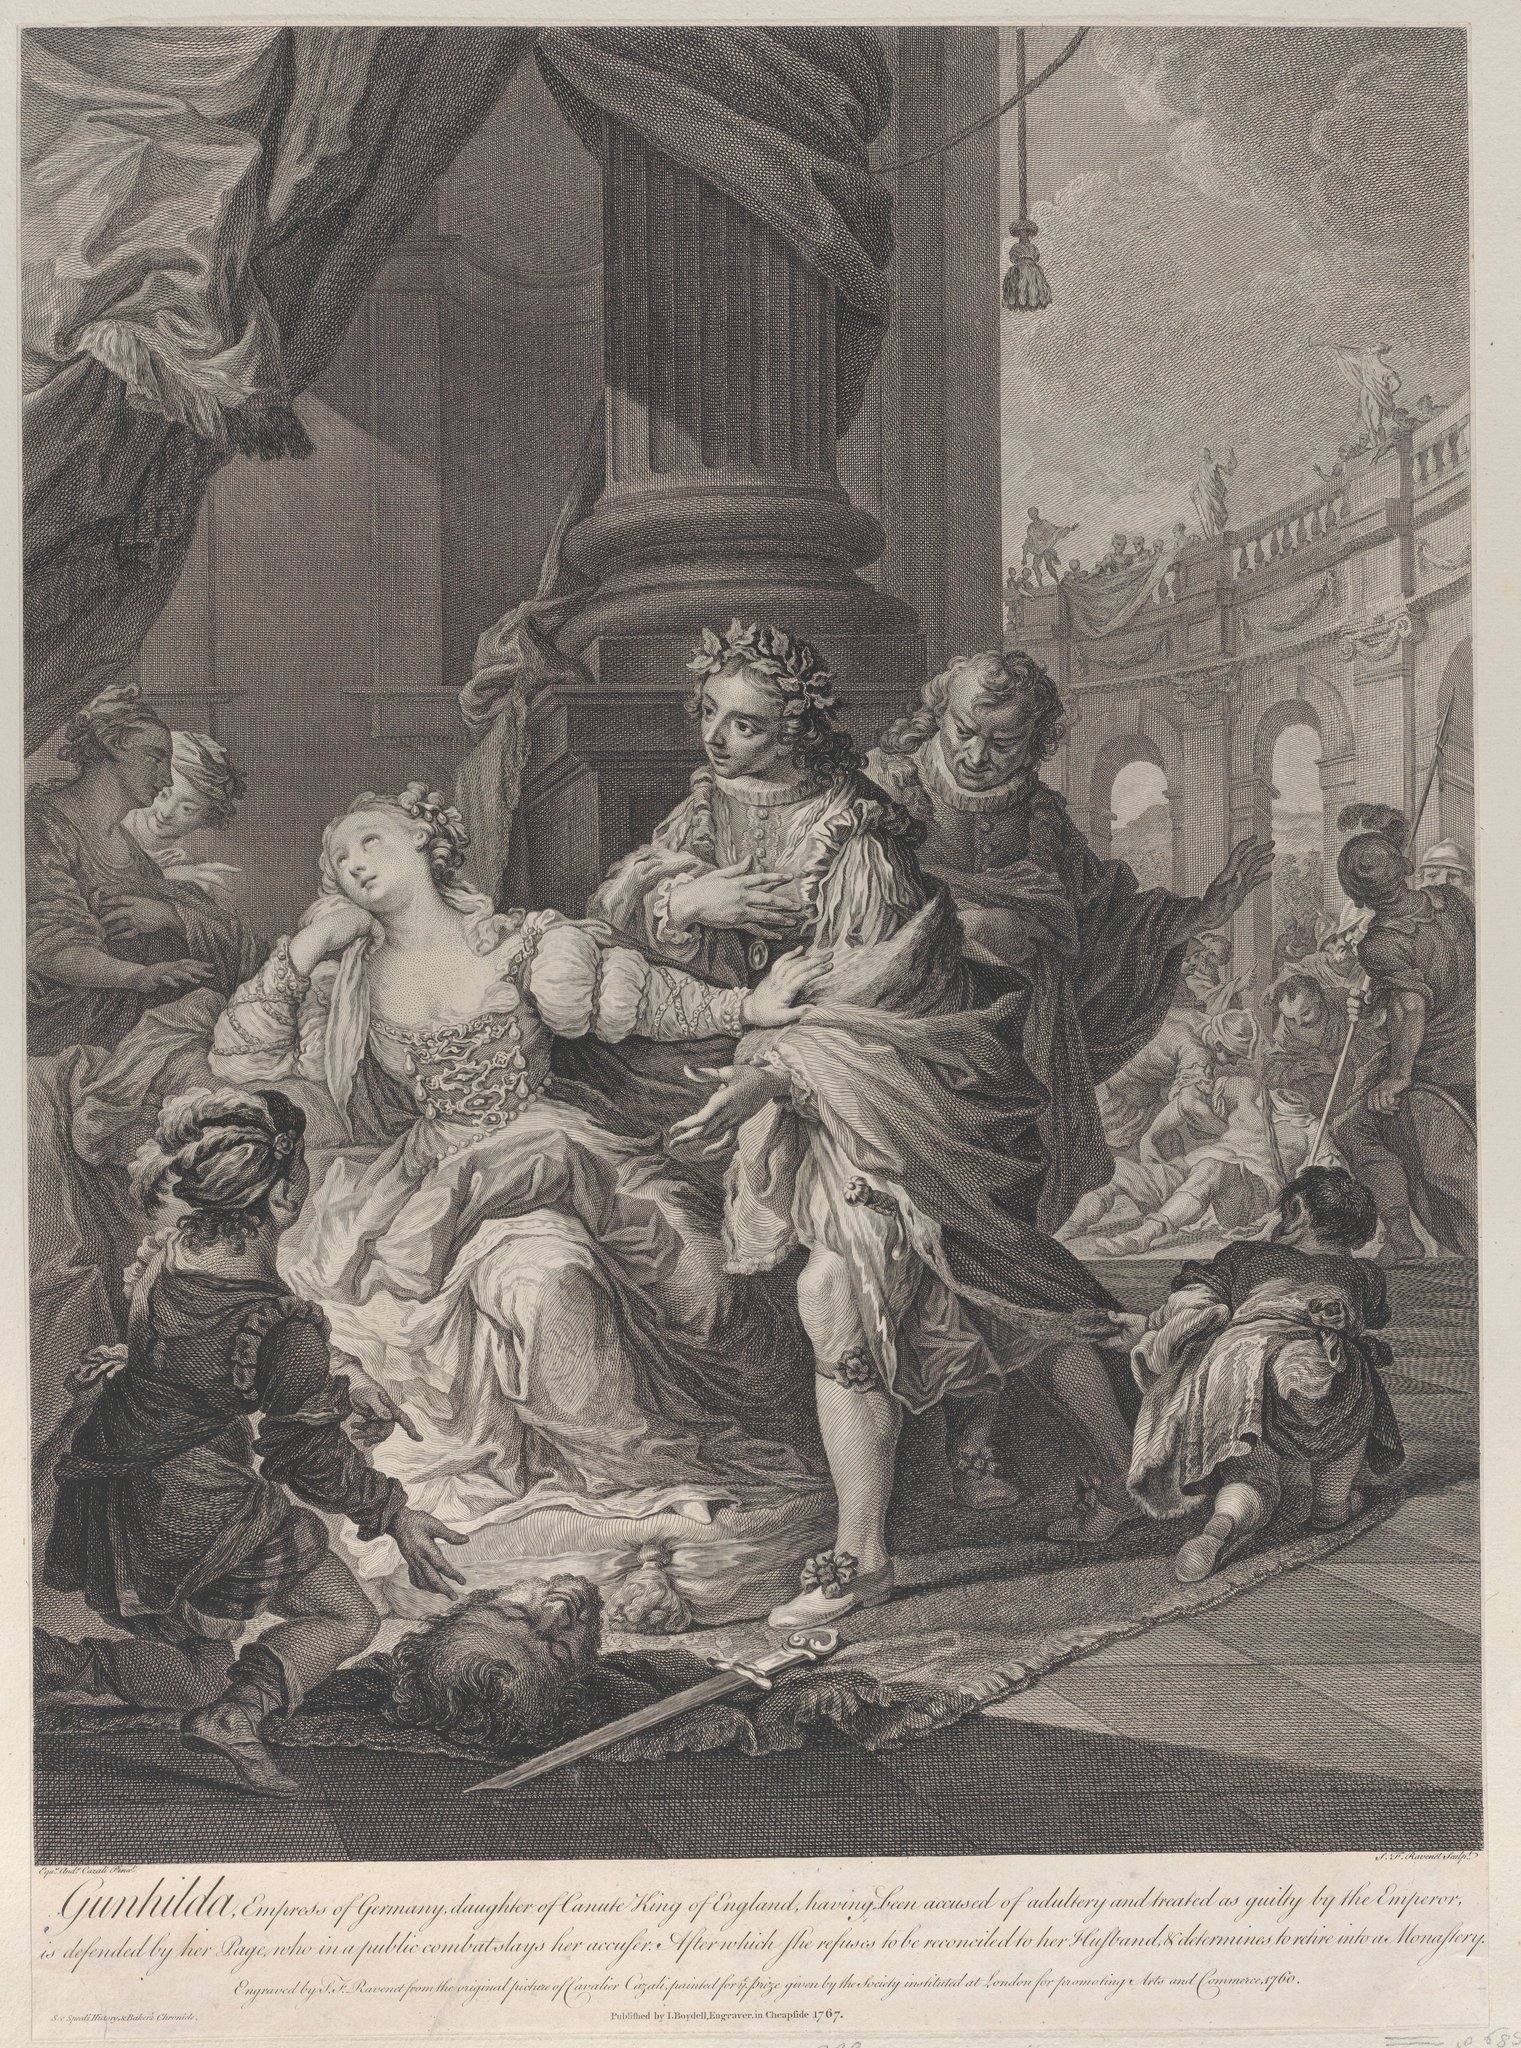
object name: print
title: Gunhilda accused of adultery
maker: simon francis ravenet, the elder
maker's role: artist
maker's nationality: french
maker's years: 1706-1774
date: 1760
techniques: engraving